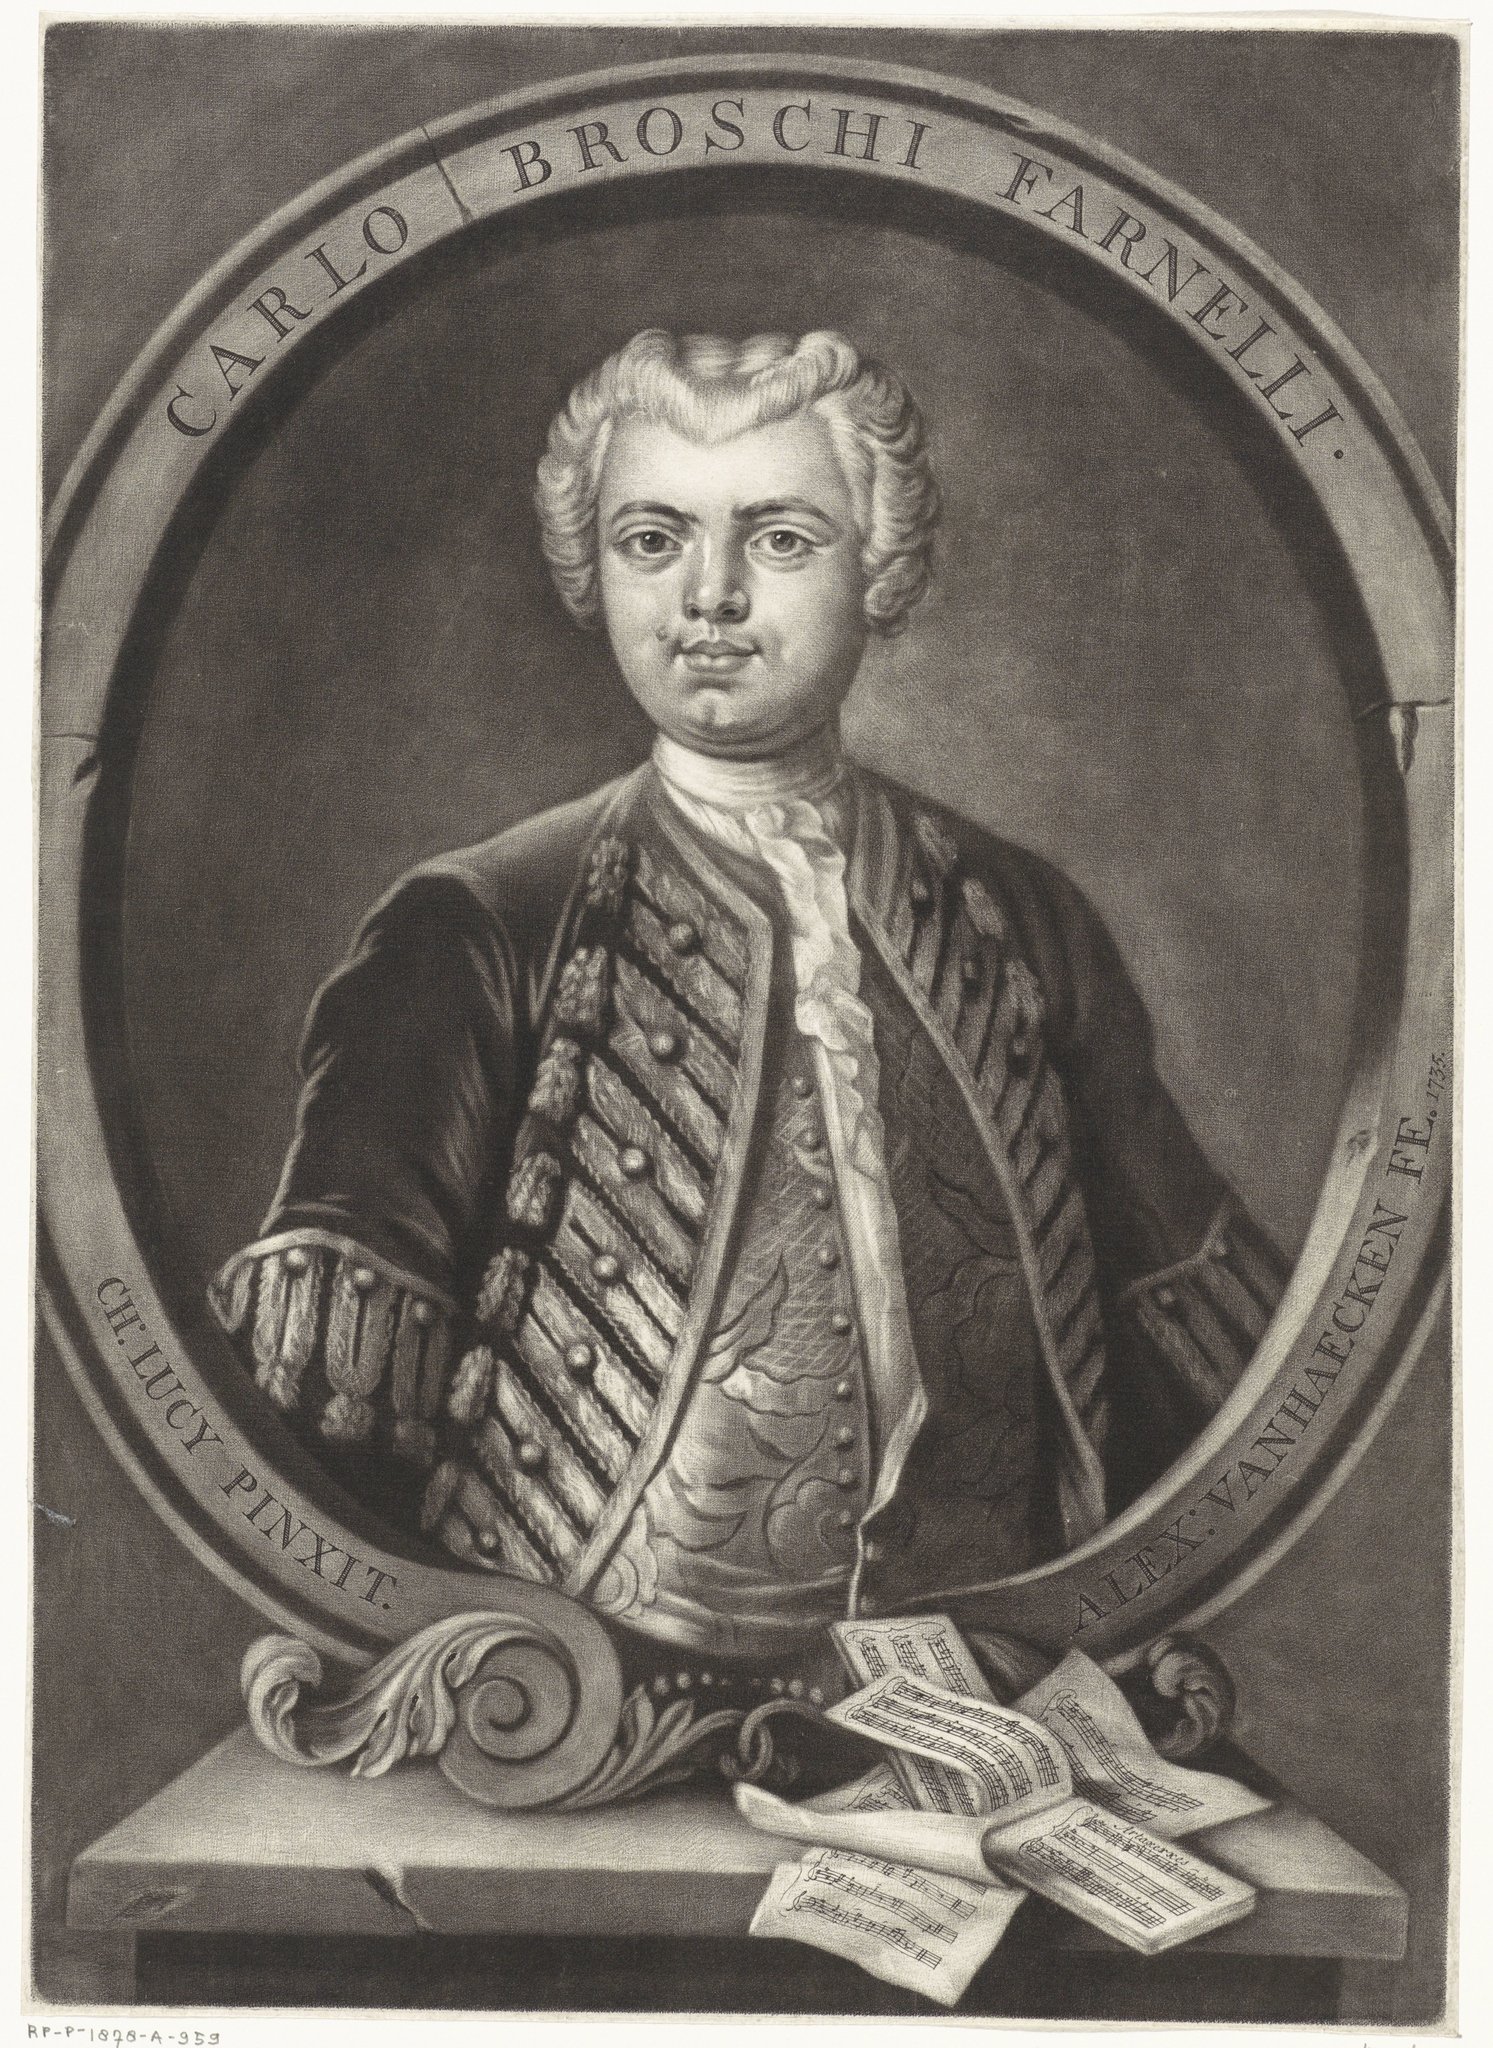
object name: print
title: Portret van Carlo Broschi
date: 1735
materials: paper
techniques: engraving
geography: london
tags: printed edition of musical score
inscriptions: collector's mark: Lugt 2228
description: De Italiaanse zanger Carlo Broschi, ook wel Farnelli genoemd. Voor hem een stapel met bladmuziek.